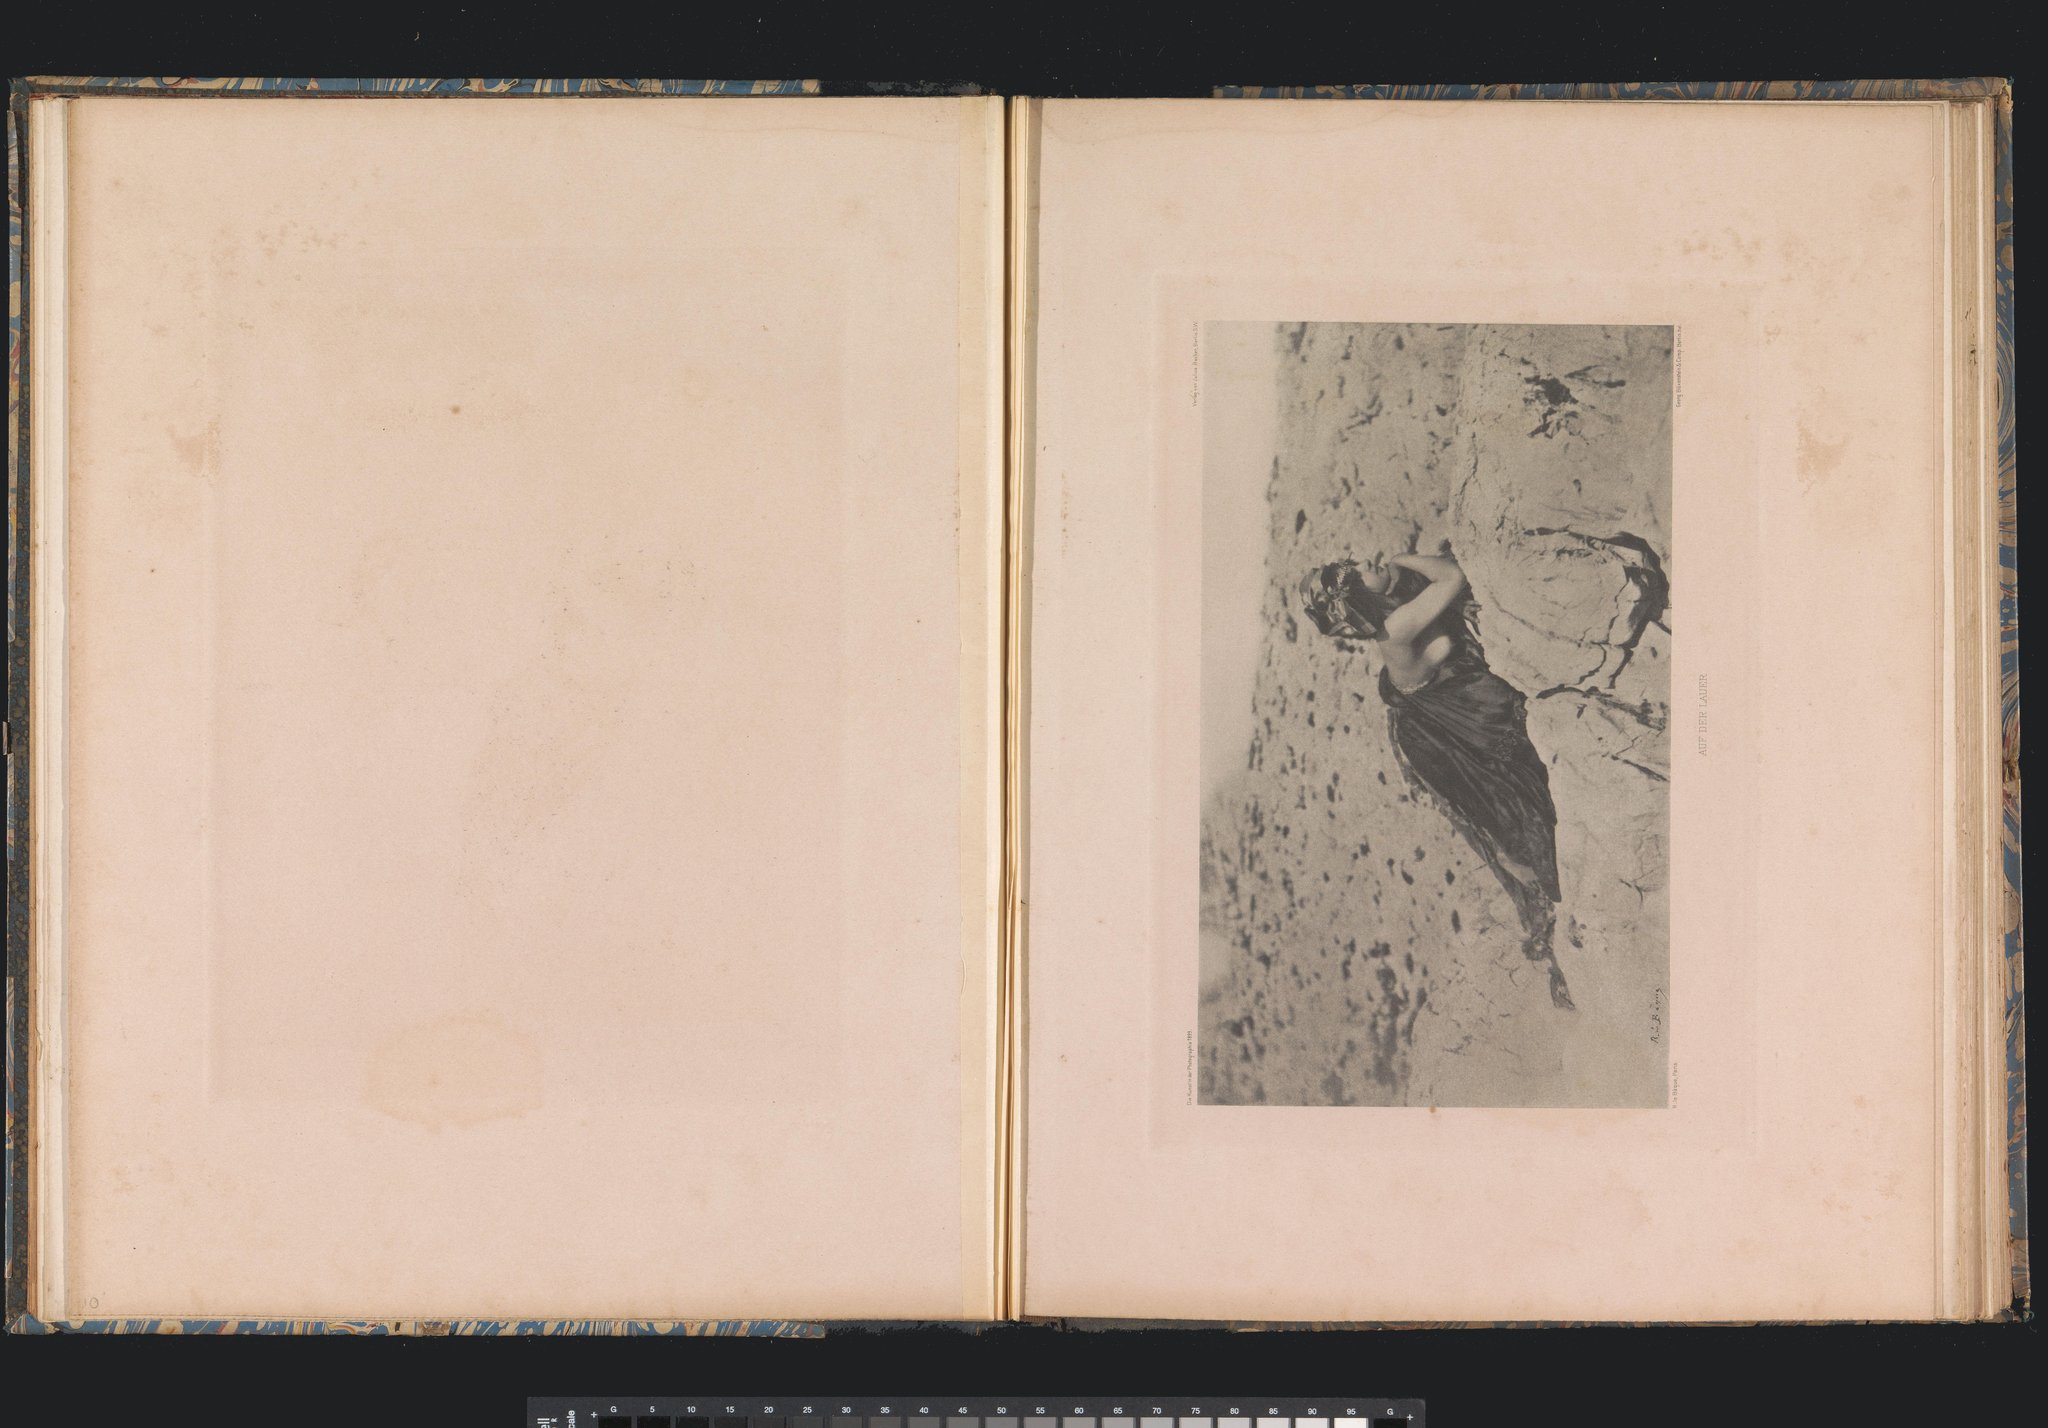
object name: page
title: Liggende vrouw in een rotslandschap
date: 1889-1899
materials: paper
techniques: photoaquatint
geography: berlin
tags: woman (showing herself) undressed, quasi-nude, lying figure - aa - female human figure, rocks